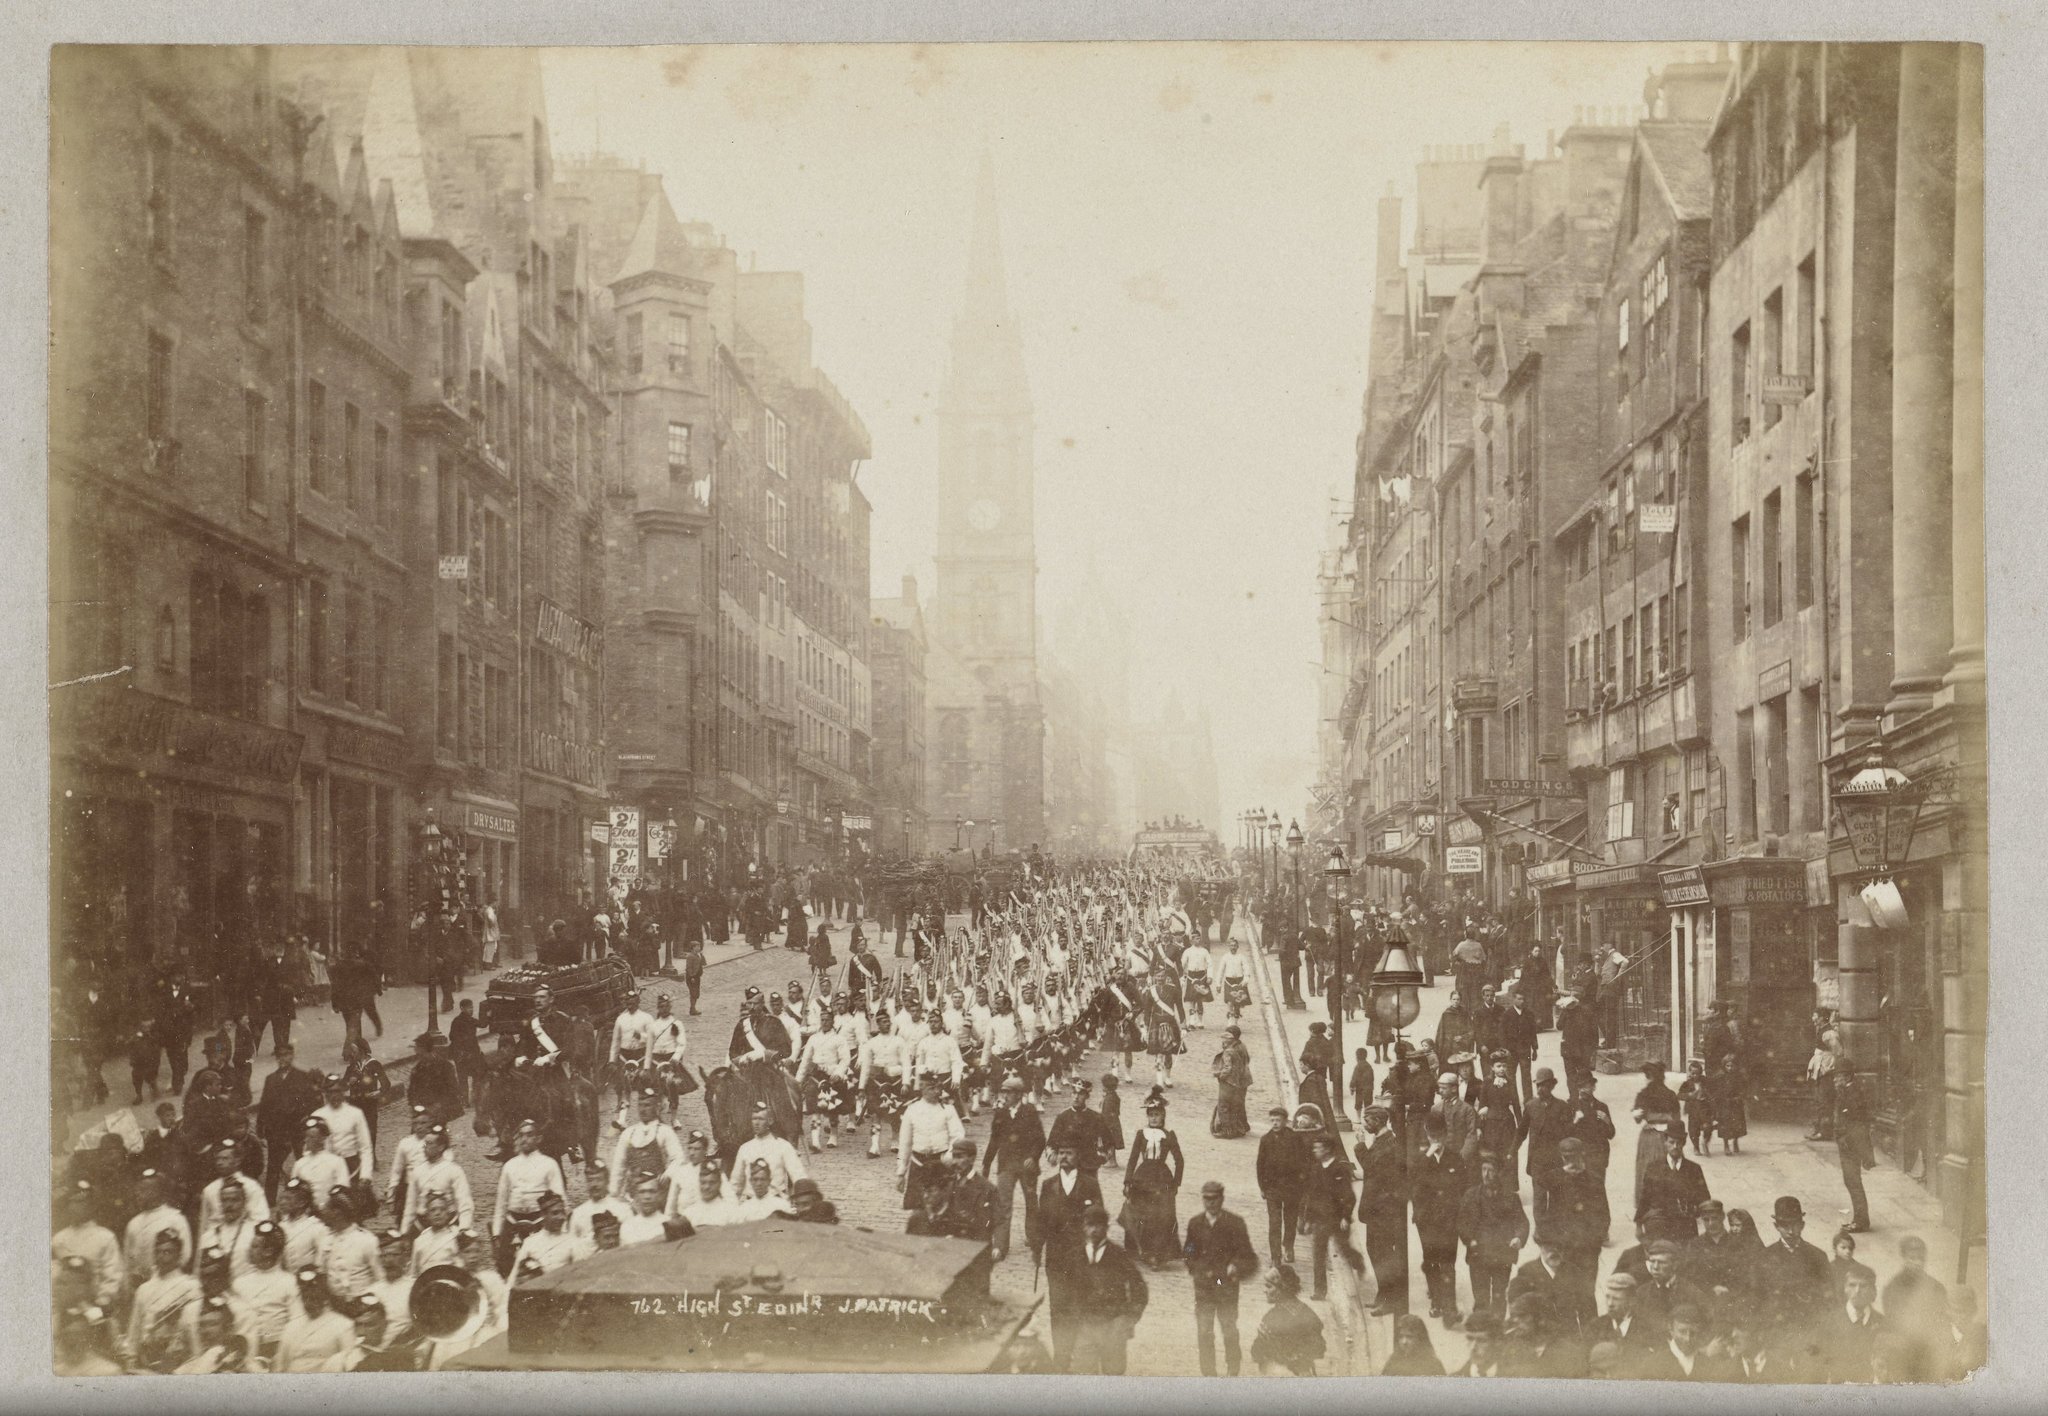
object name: photograph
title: High St, Edinr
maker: john patrick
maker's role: fotograaf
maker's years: 1831-1923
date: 1881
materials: cardboard, paper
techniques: albumen print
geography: edinburgh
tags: military parade, pageant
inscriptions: number: ‘762’